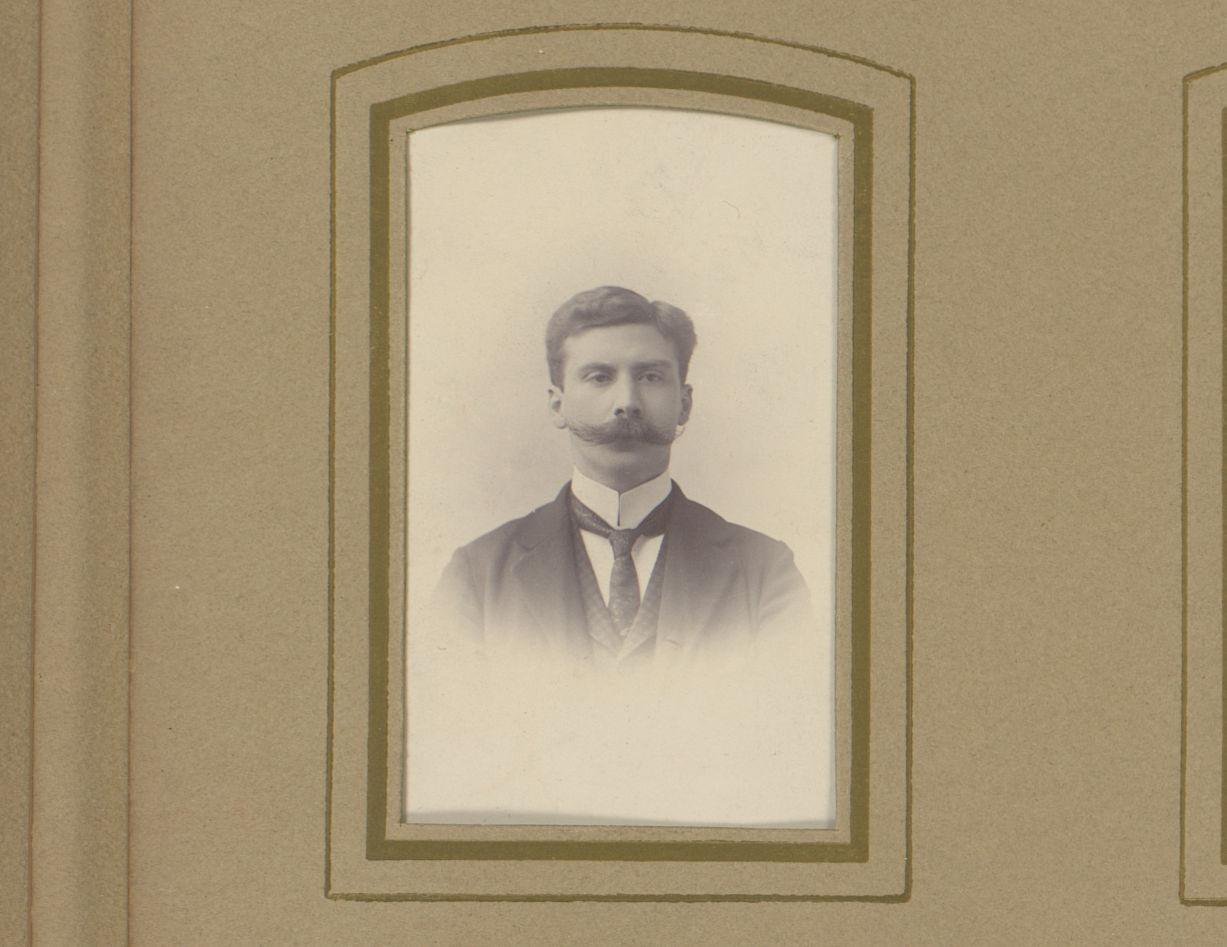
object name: carte de visite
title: Portret van een man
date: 1894-1907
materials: cardboard, photographic support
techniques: matte daylight collodion silver print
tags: historical persons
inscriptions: inscription: ‘Koene & Büttinghausen/ Amsterdam/ Heerengracht 150./ Telephoonnummer 1402./ Batavia.’